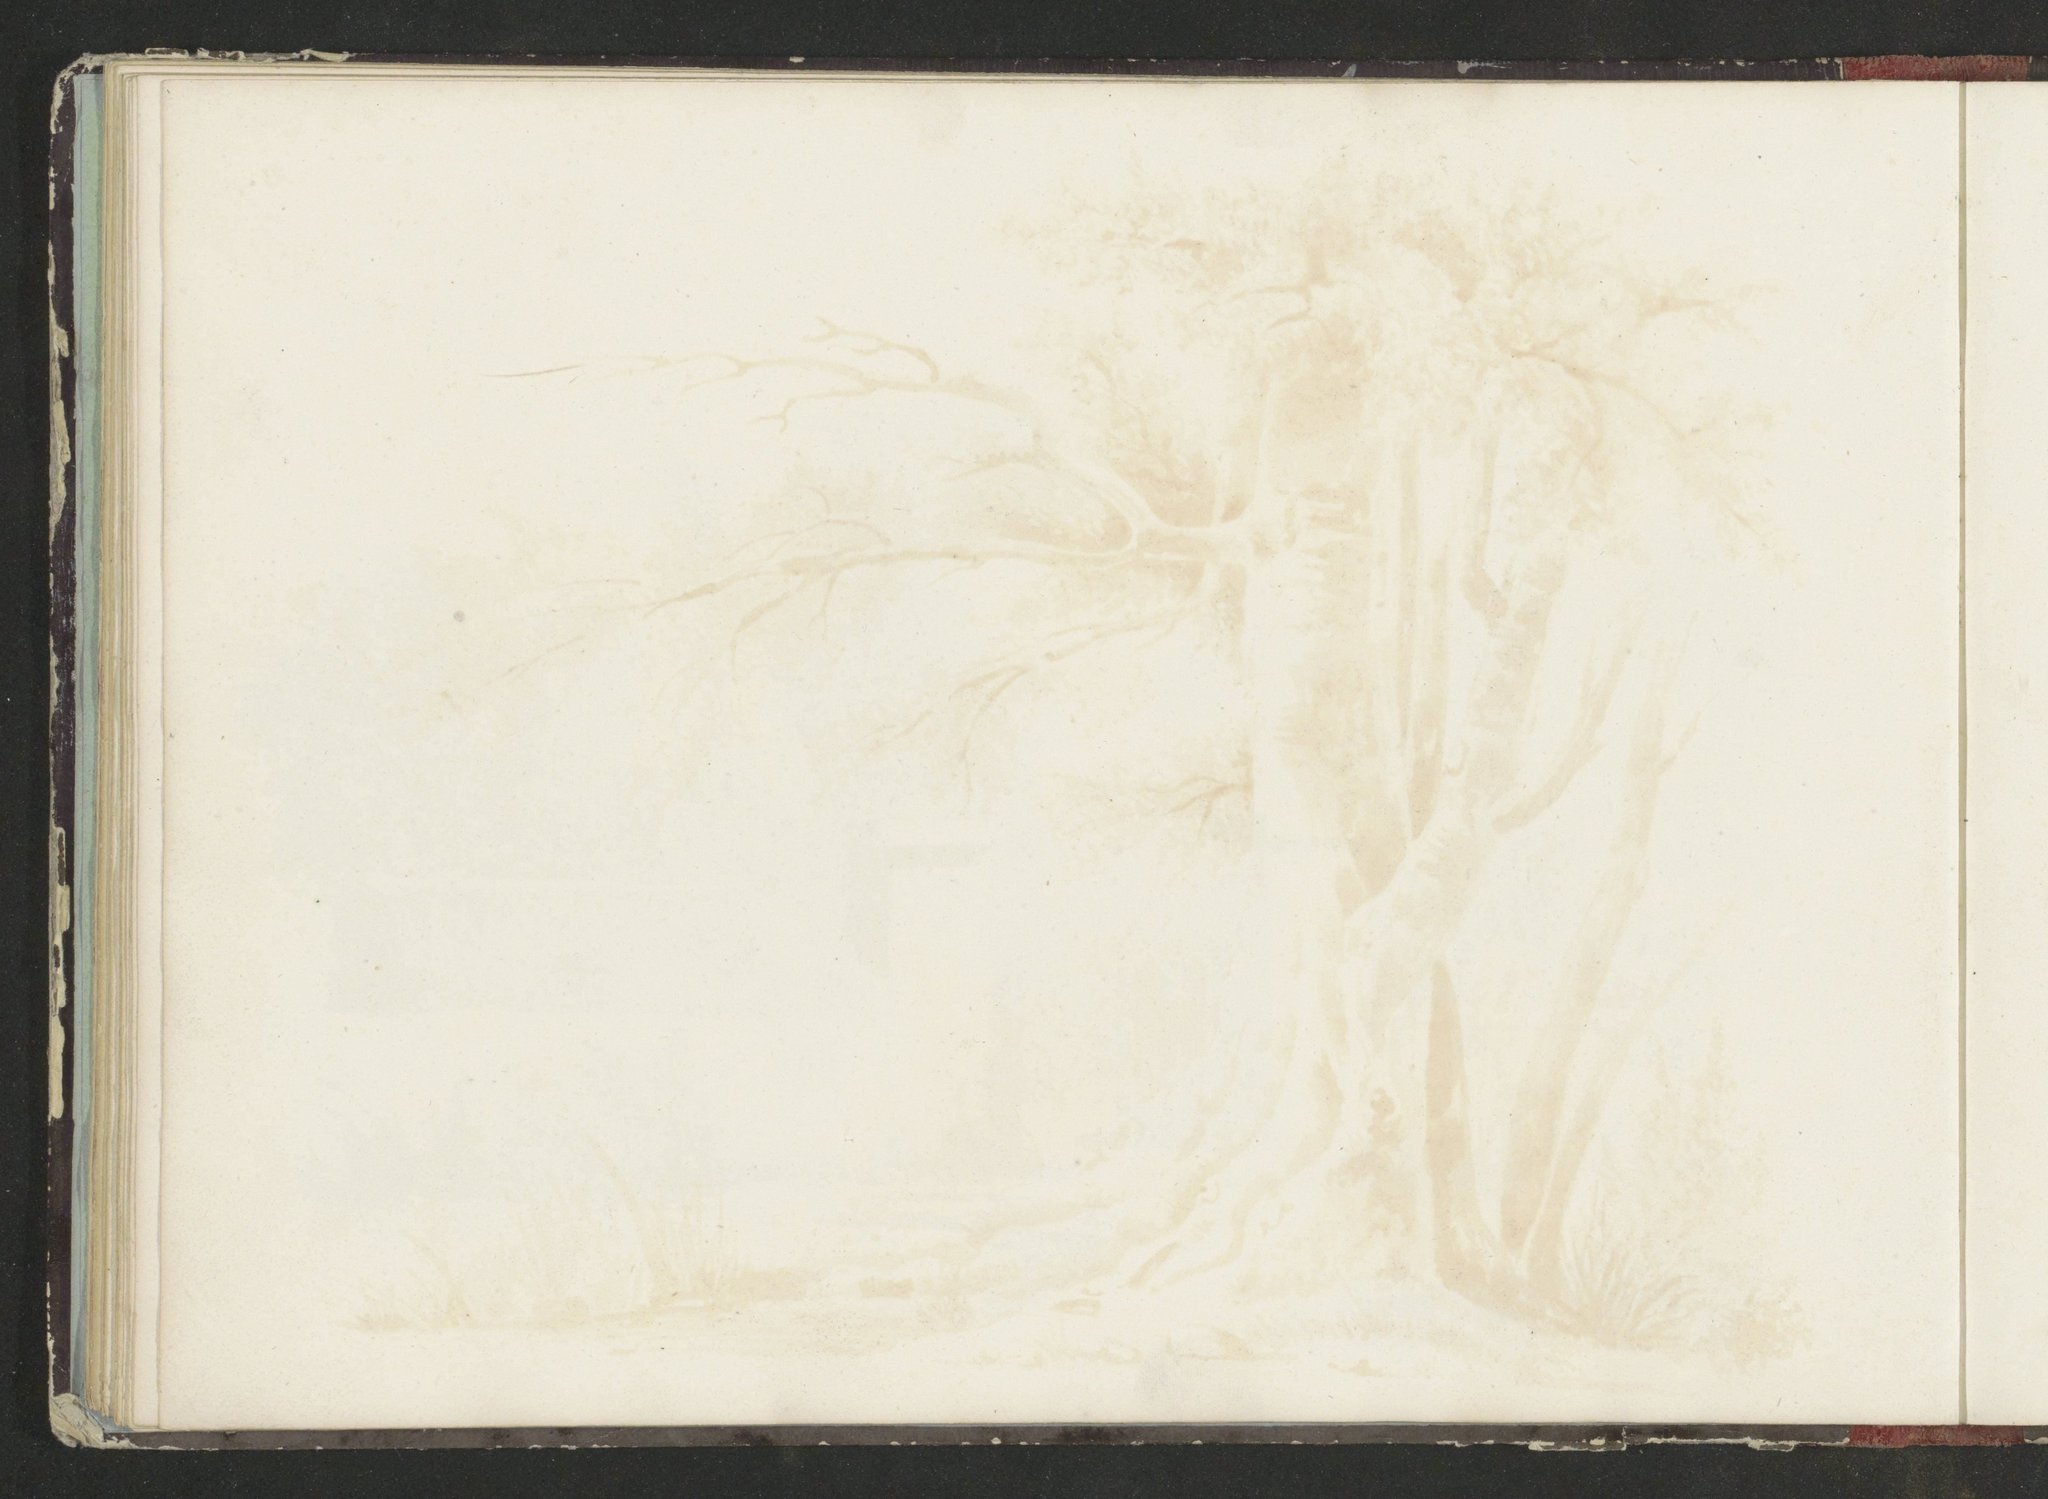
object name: sketchbook leaf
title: Abklatsch van de tekening op blad 18 recto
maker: Anonymous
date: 1819-1870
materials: paper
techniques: printmaking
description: Blad 17 verso uit een schetsboek met 39 bladen.